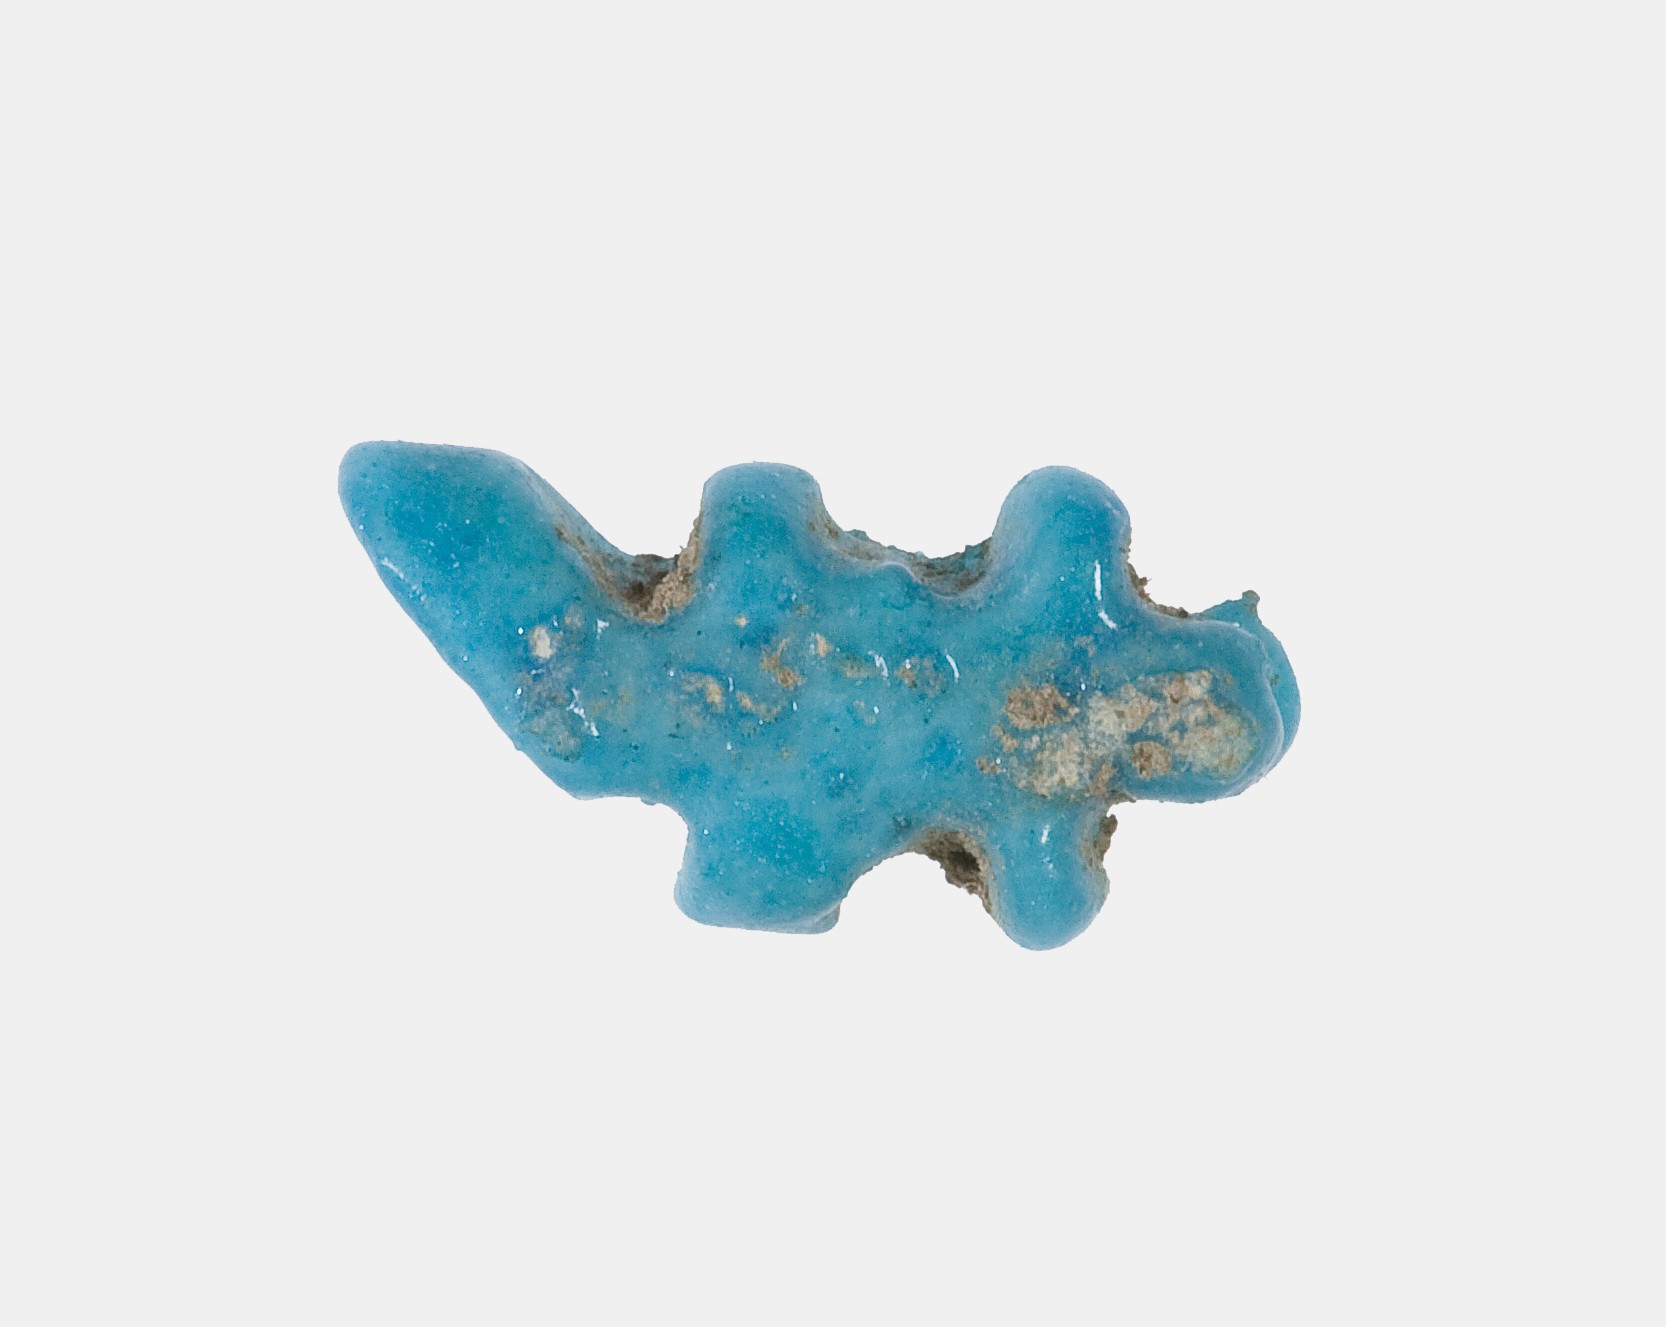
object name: amulet, scorpion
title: Scorpion Amulet (?)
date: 1802-1450 BCE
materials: faience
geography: egypt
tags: scorpions